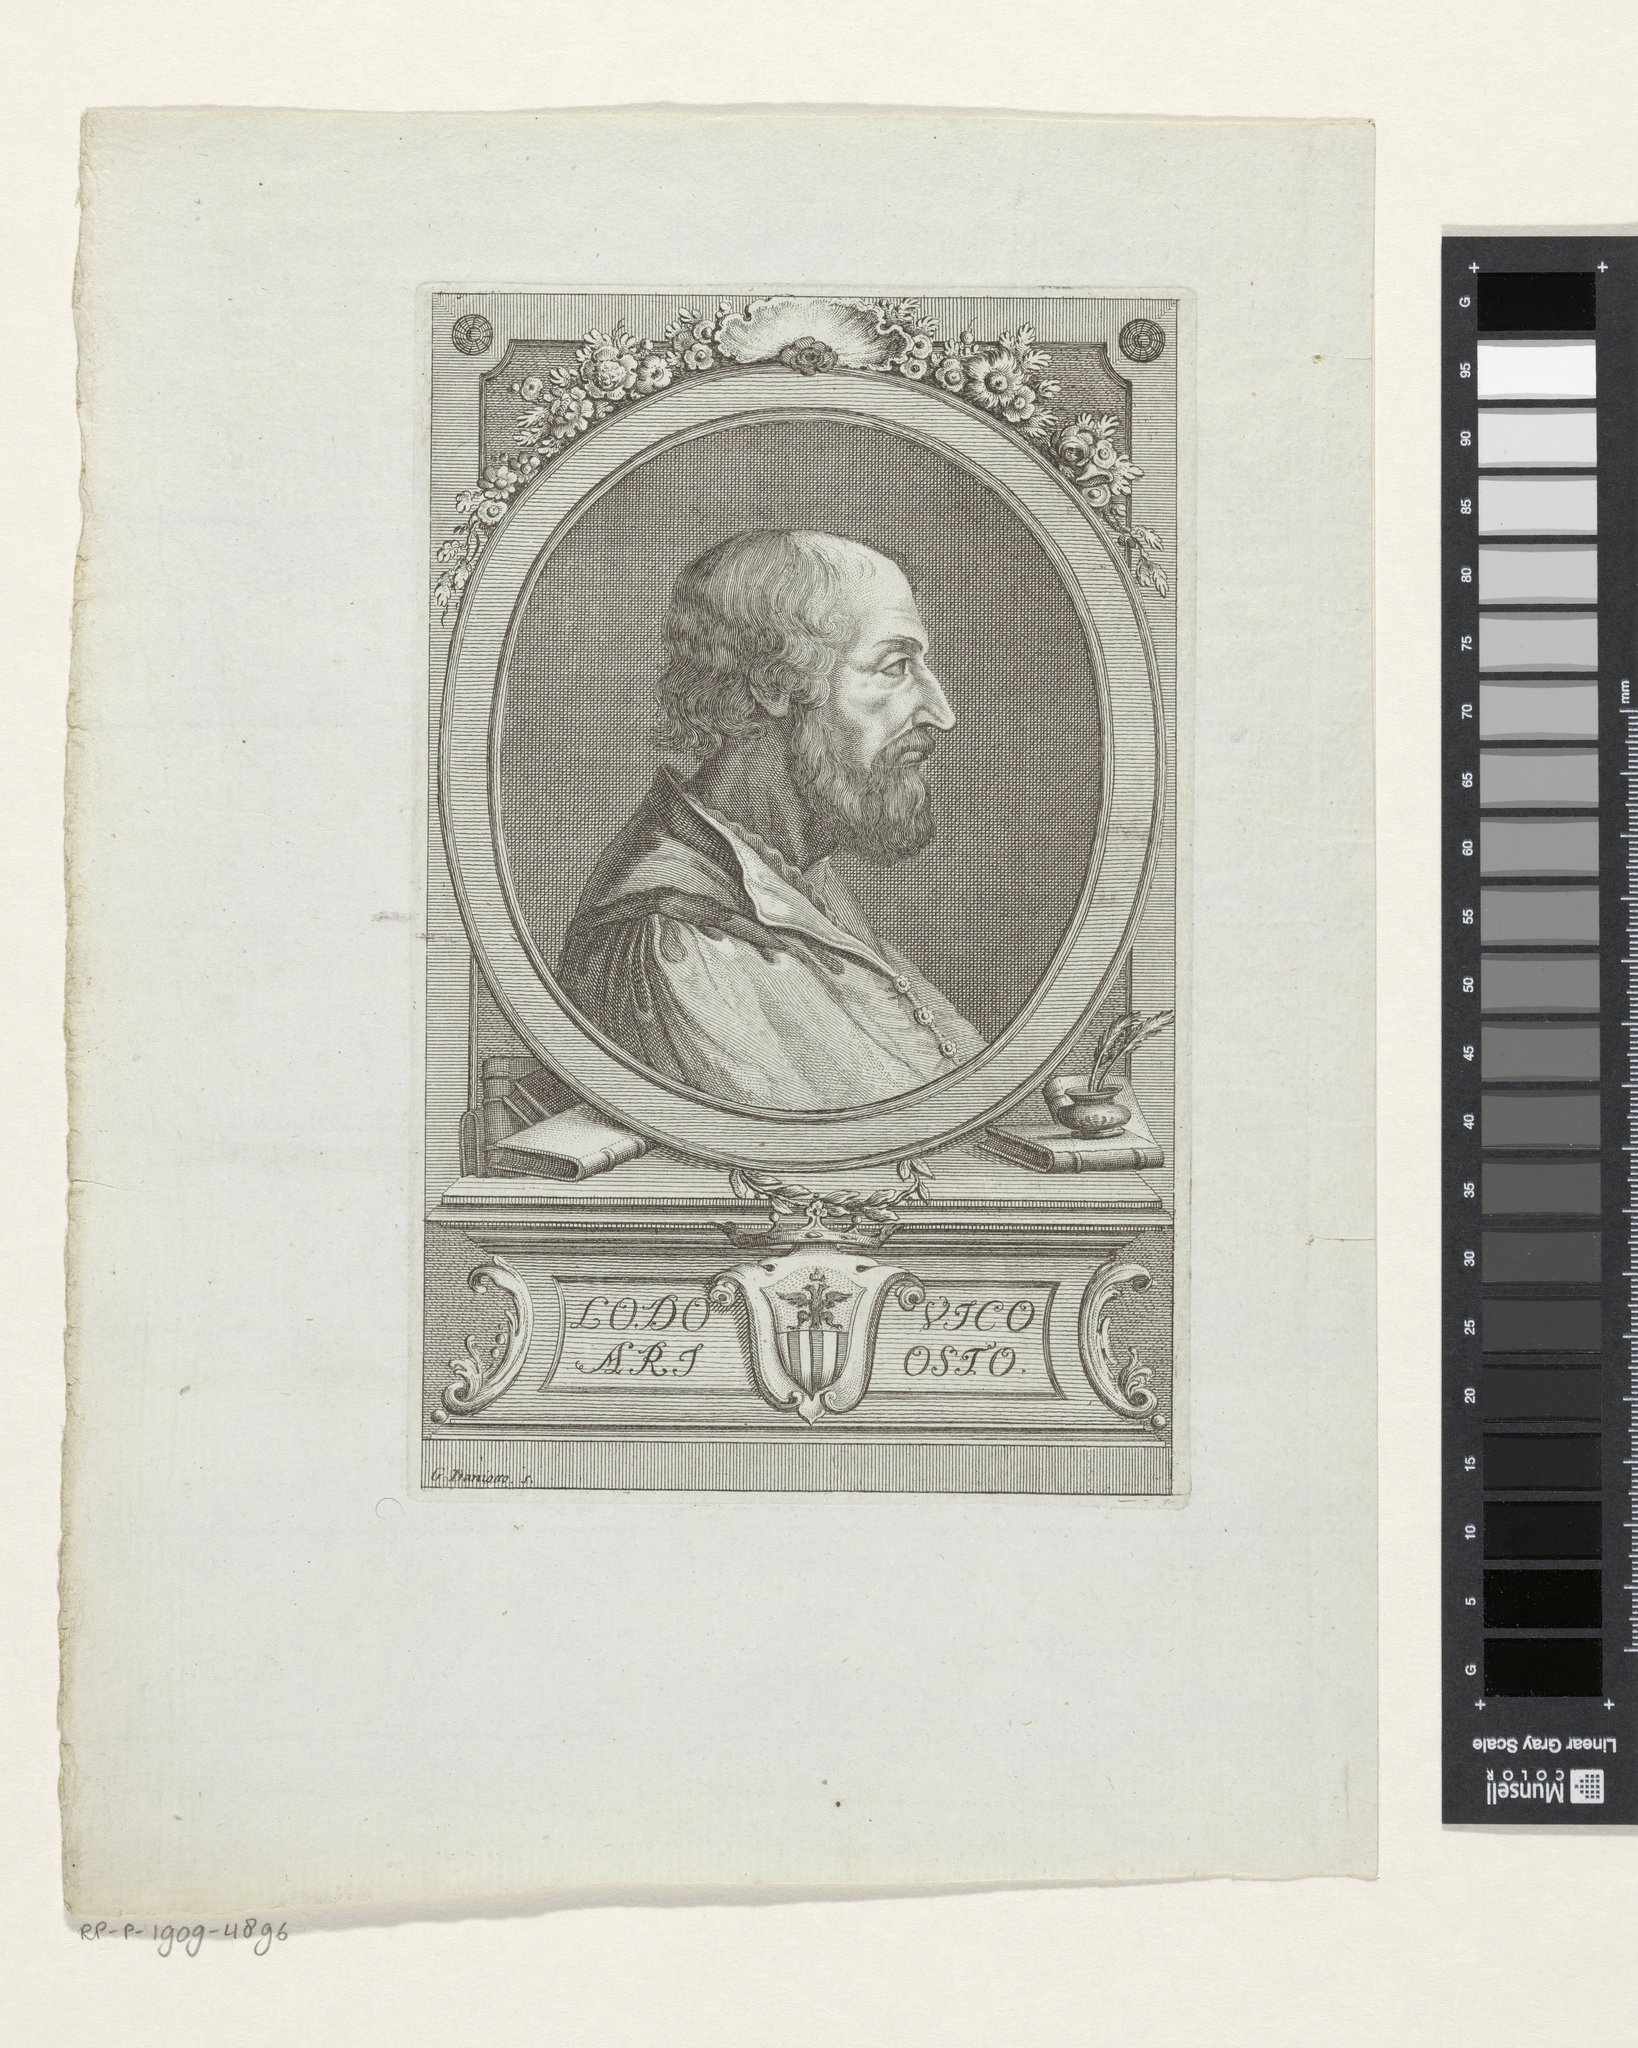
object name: print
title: Portret van dichter Ludovico Ariosto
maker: giuseppe daniotto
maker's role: print maker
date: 1700-1799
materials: paper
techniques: etching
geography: italy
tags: ludovico ariosto, historical persons, portrait of a writer, writer, poet, author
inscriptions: collector's mark: Lugt 2228